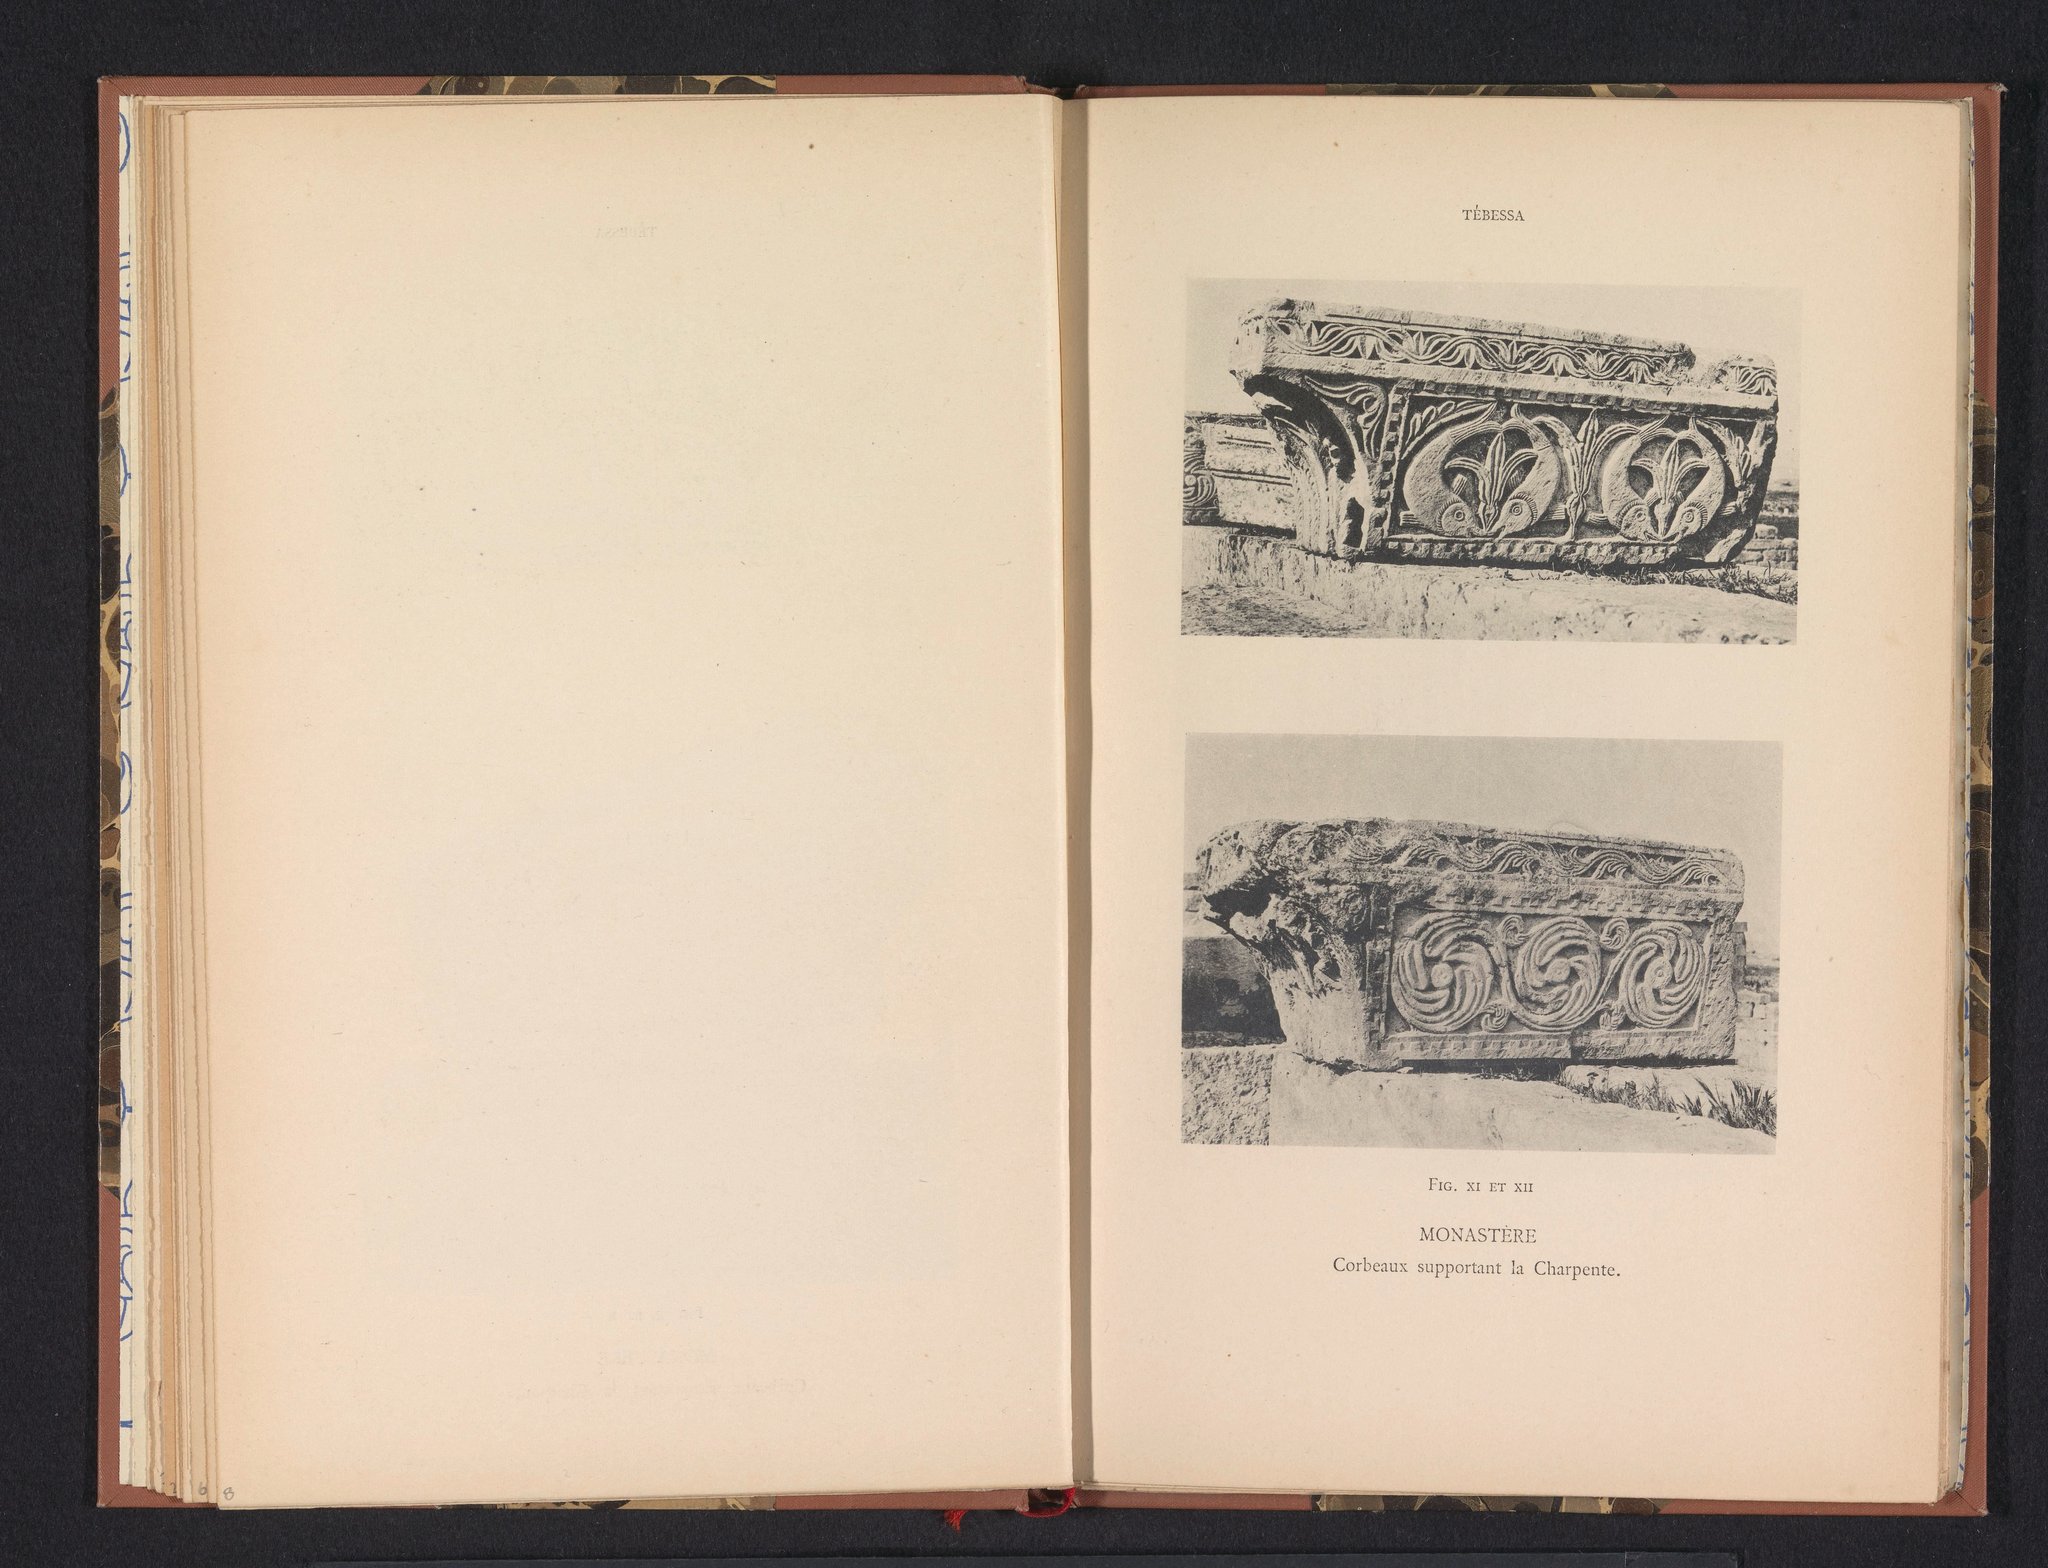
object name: photomechanical print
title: Twee kraagstenen van de ruïne van een kloosterkerk in Tébessa, gedecoreerd met vissengolven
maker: Anonymous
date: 1884-1894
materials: paper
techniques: photograph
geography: france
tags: column, pillar ~ architecture, ruin of church, monastery, etc.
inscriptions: number: ‘Fig. XI et XII’